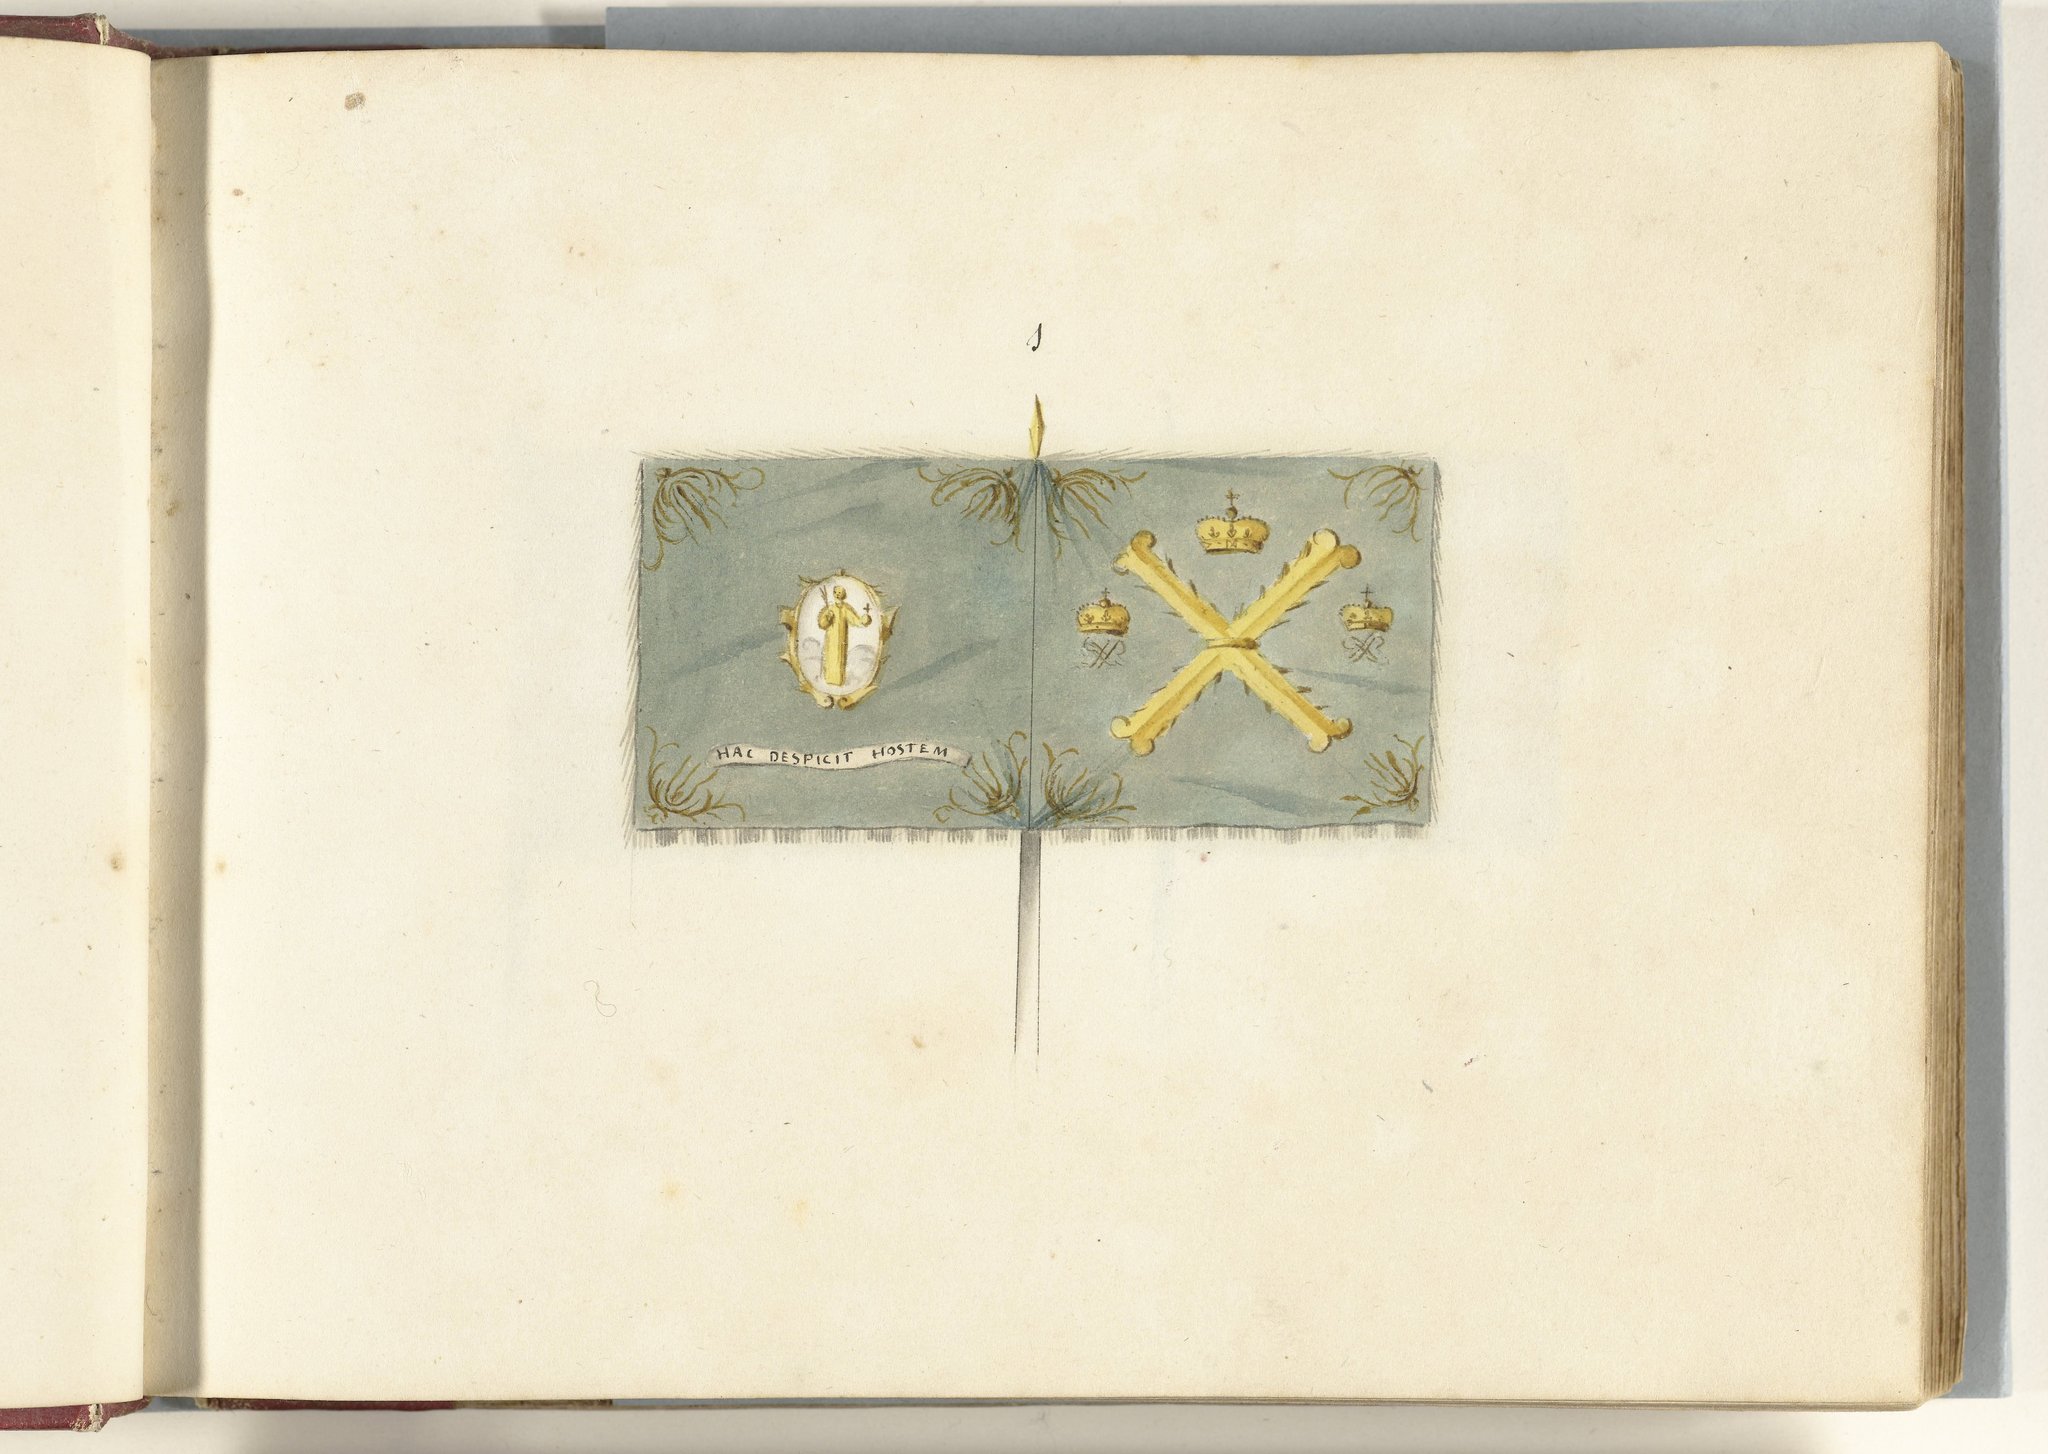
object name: drawing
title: Frans standaard veroverd in de slag bij Spierbach, 1703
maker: Anonymous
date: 1713-1720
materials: paper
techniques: drawing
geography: northern netherlands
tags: (military) flags and standards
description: Frans standaard veroverd in de slag bij Spierbach, 1703. In het boek met tekeningen van Franse vaandels, standaarden en pauken, veroverd tijdens de Spaanse Successieoorlog (1701-1713).